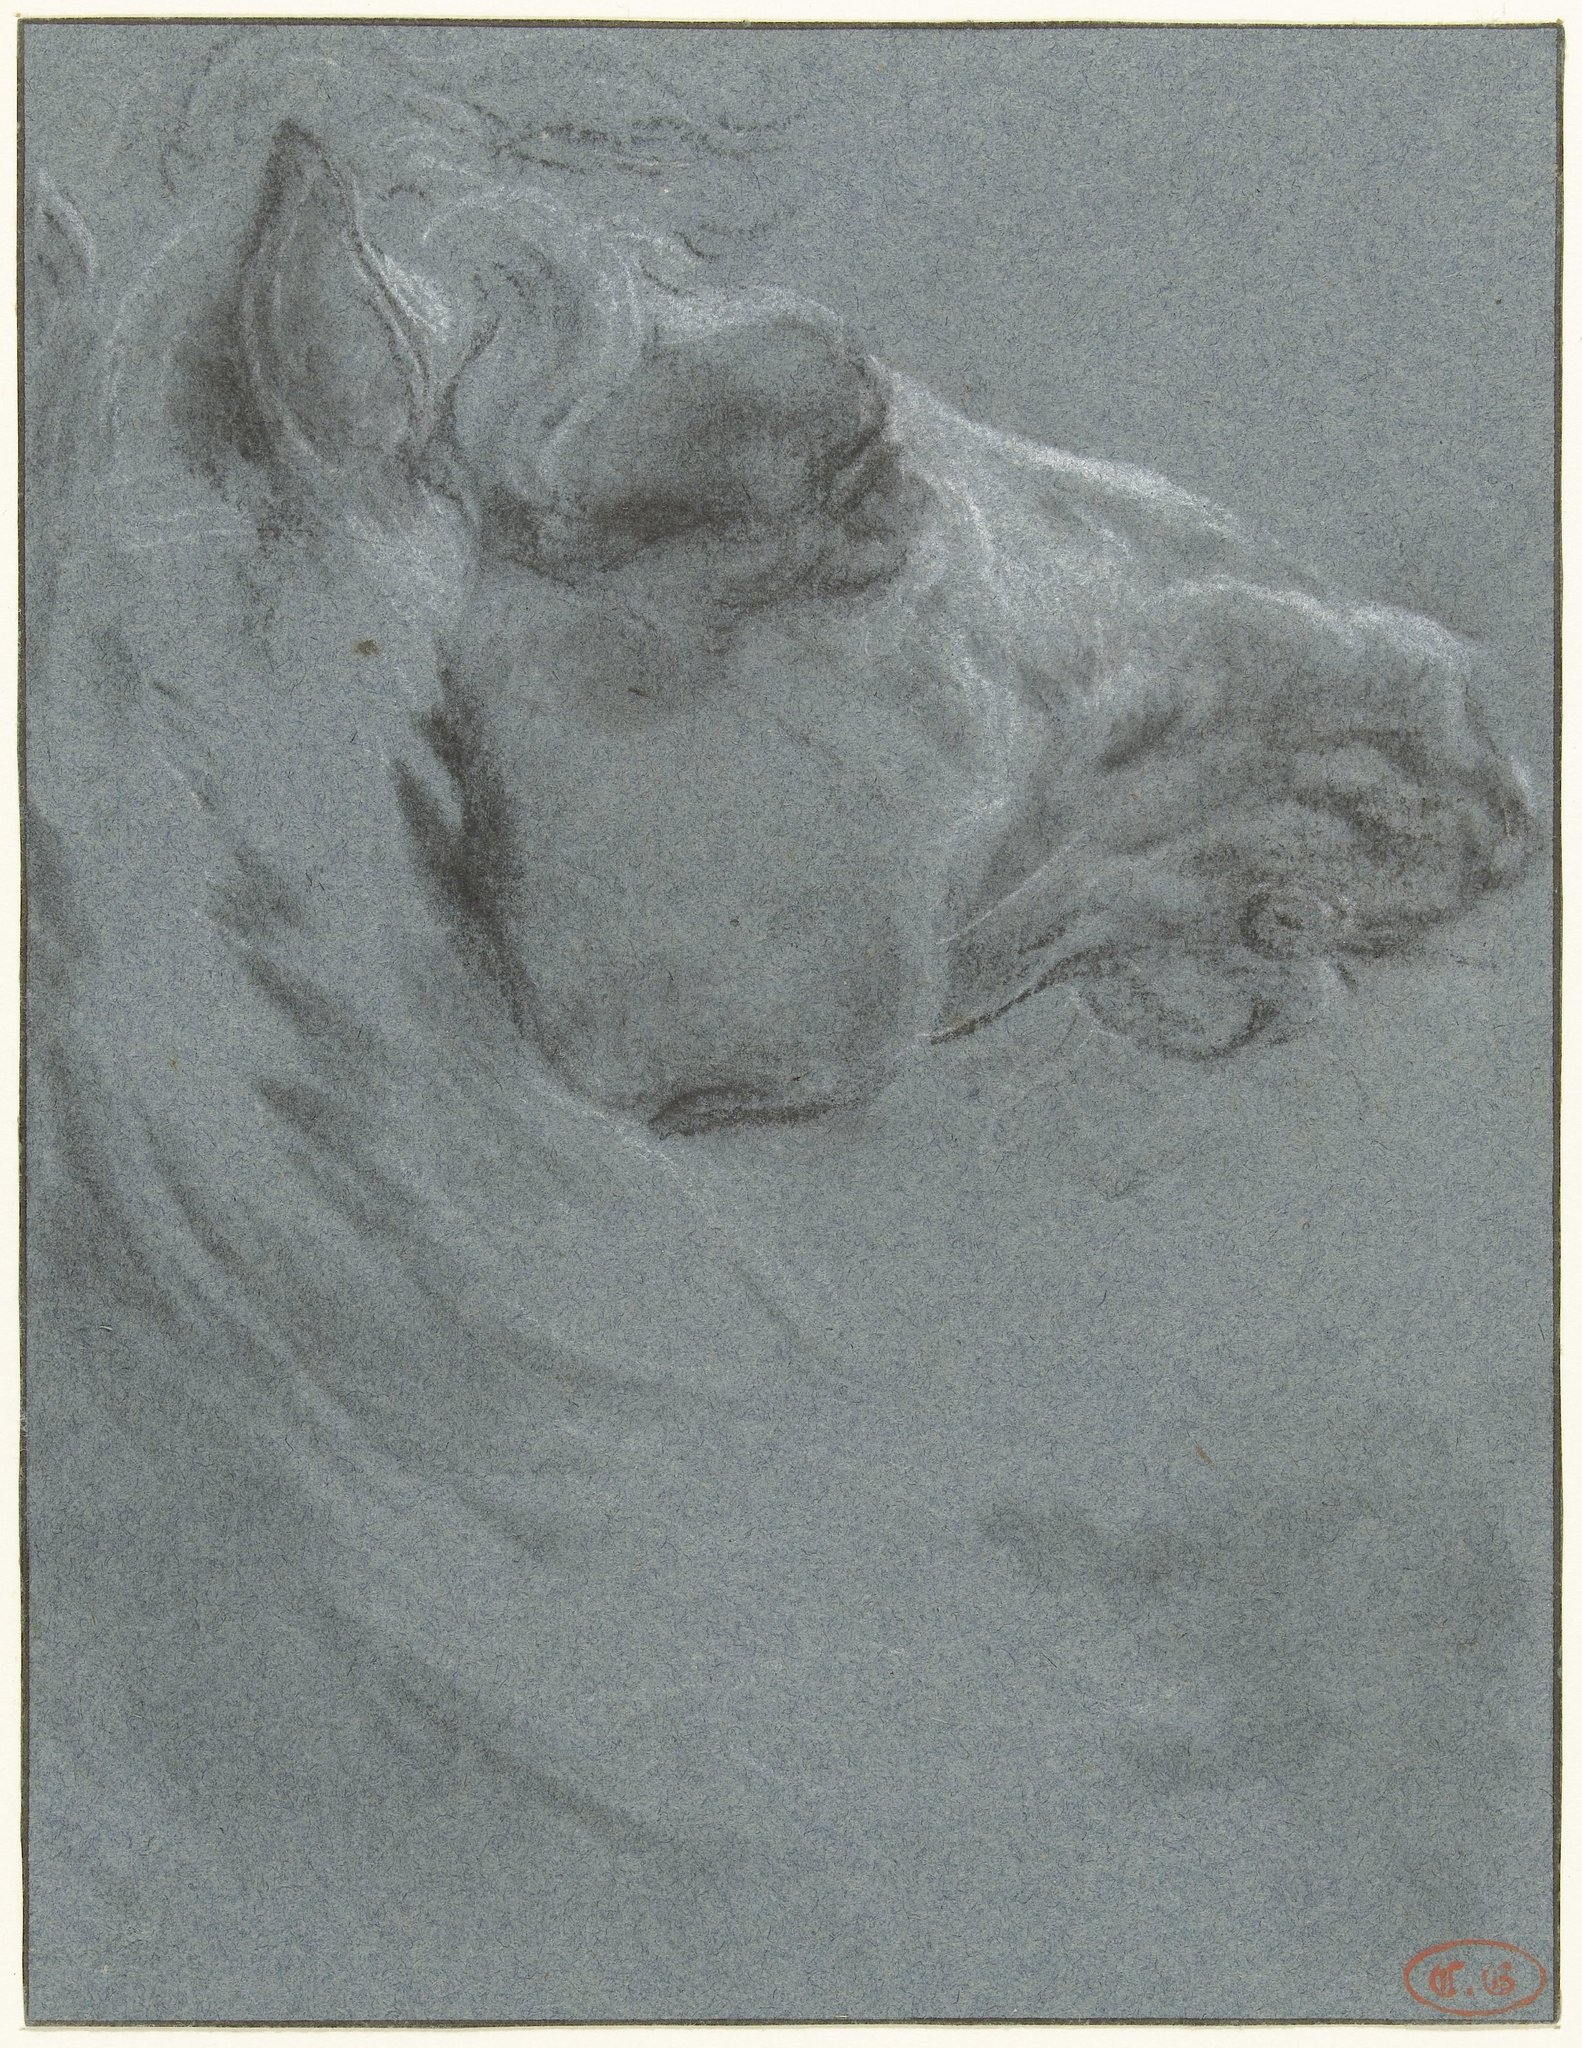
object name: drawing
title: Hoofd van een paard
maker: francesco giuseppe casanova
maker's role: draughtsman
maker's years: 1727-1802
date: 1737-1802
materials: chalk, paper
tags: horse (+ head of an animal)